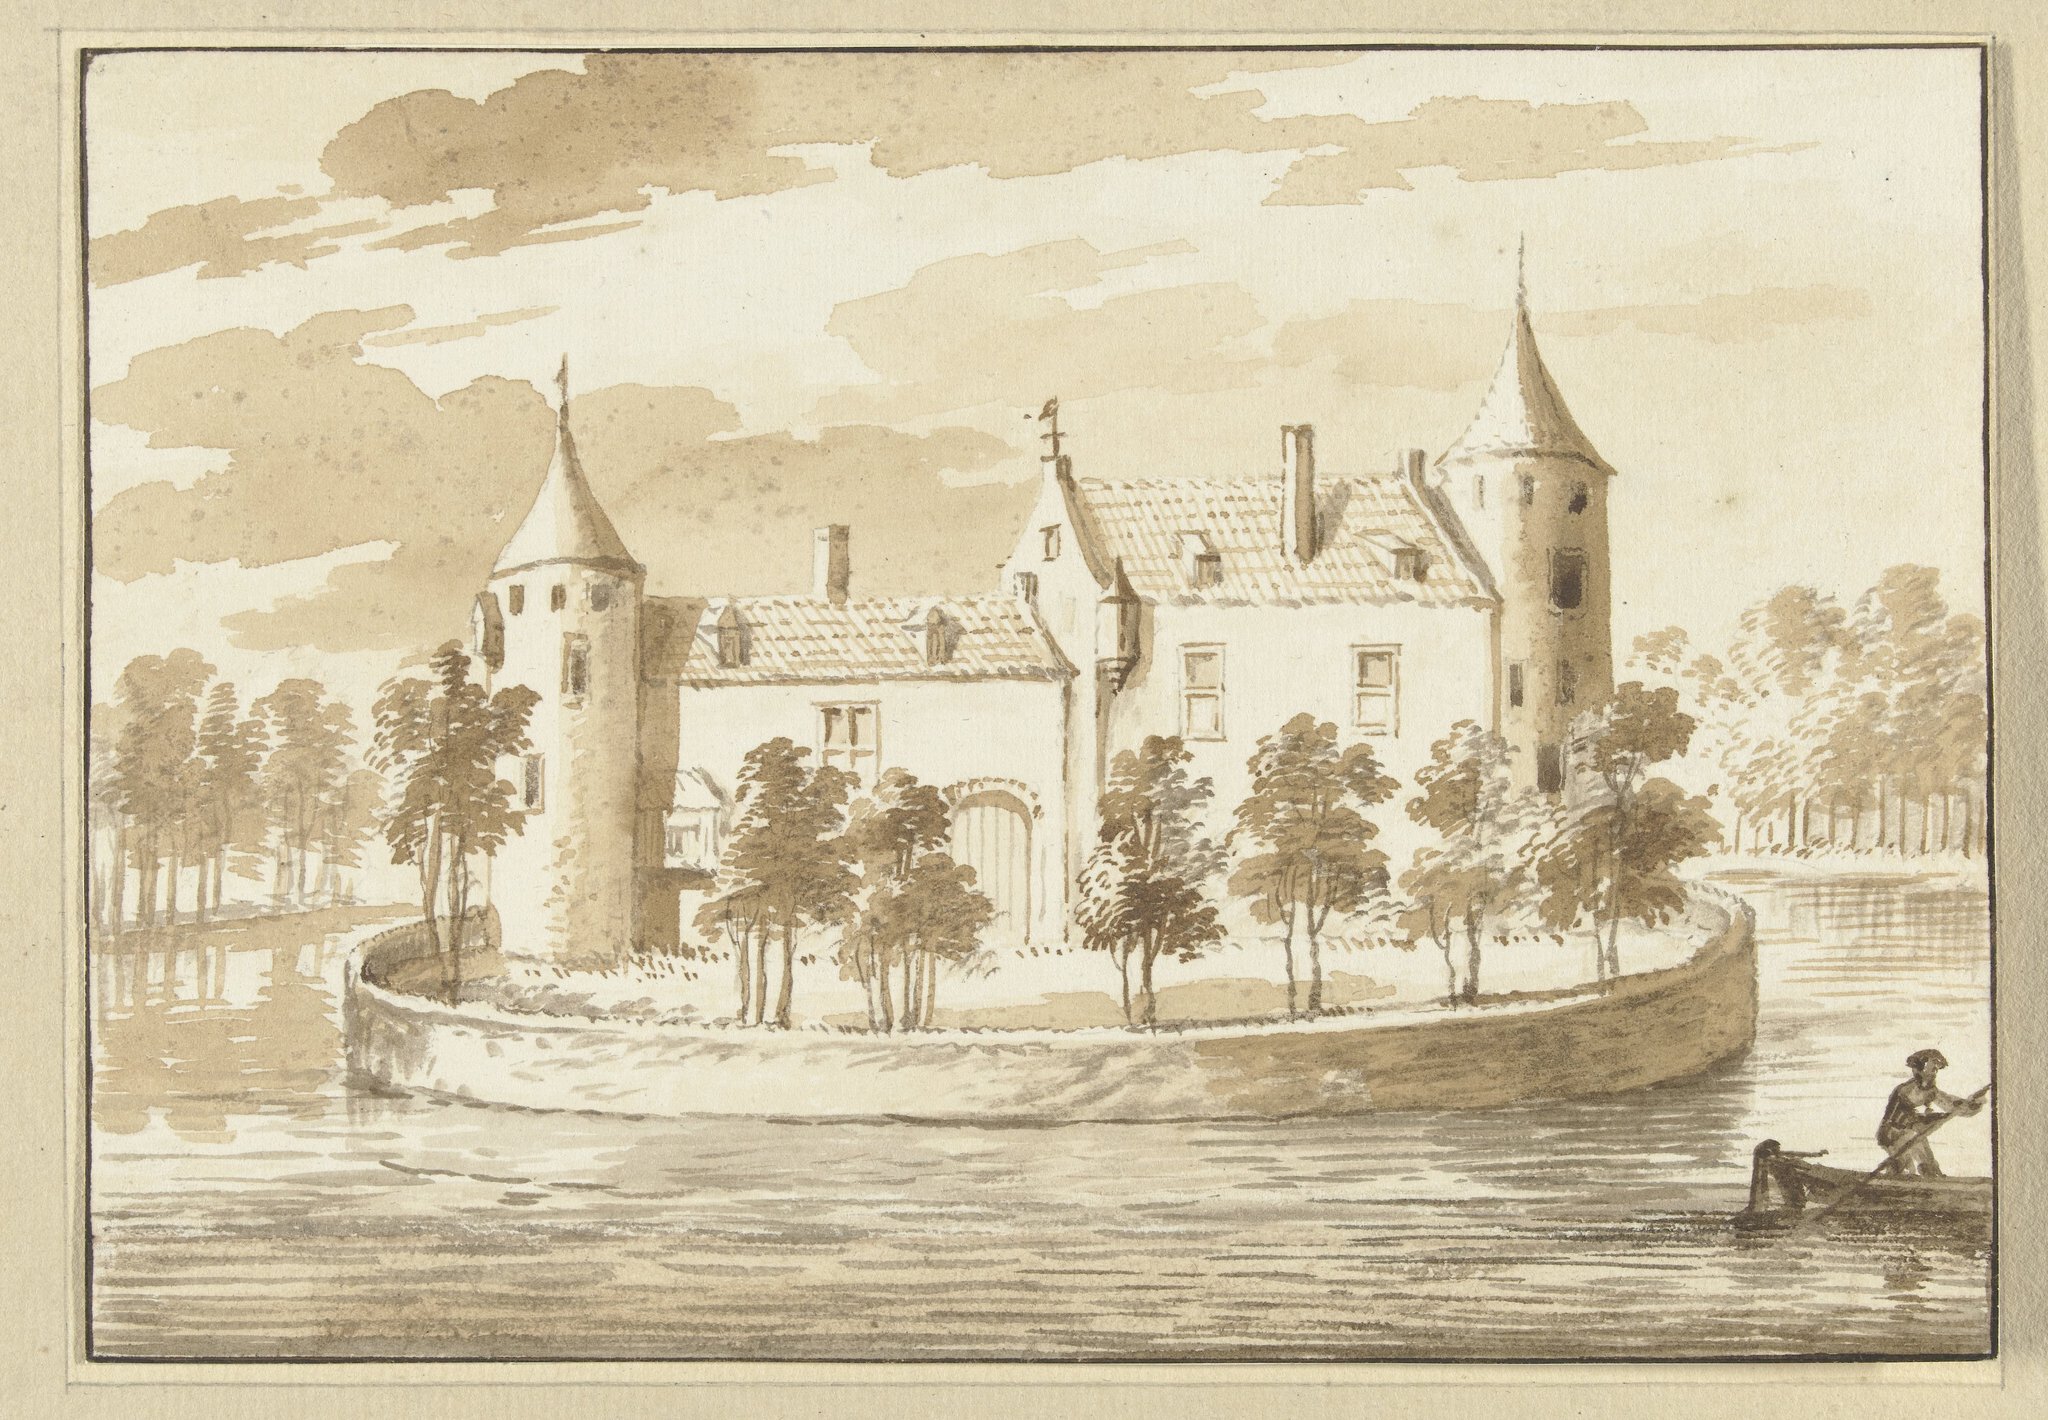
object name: drawing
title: Huis te Baarsdorp op Zuid-Beveland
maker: abraham rademaker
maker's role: draughtsman, print maker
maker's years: 1676-1735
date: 1685-1735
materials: paper, pencil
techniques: brush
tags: castle